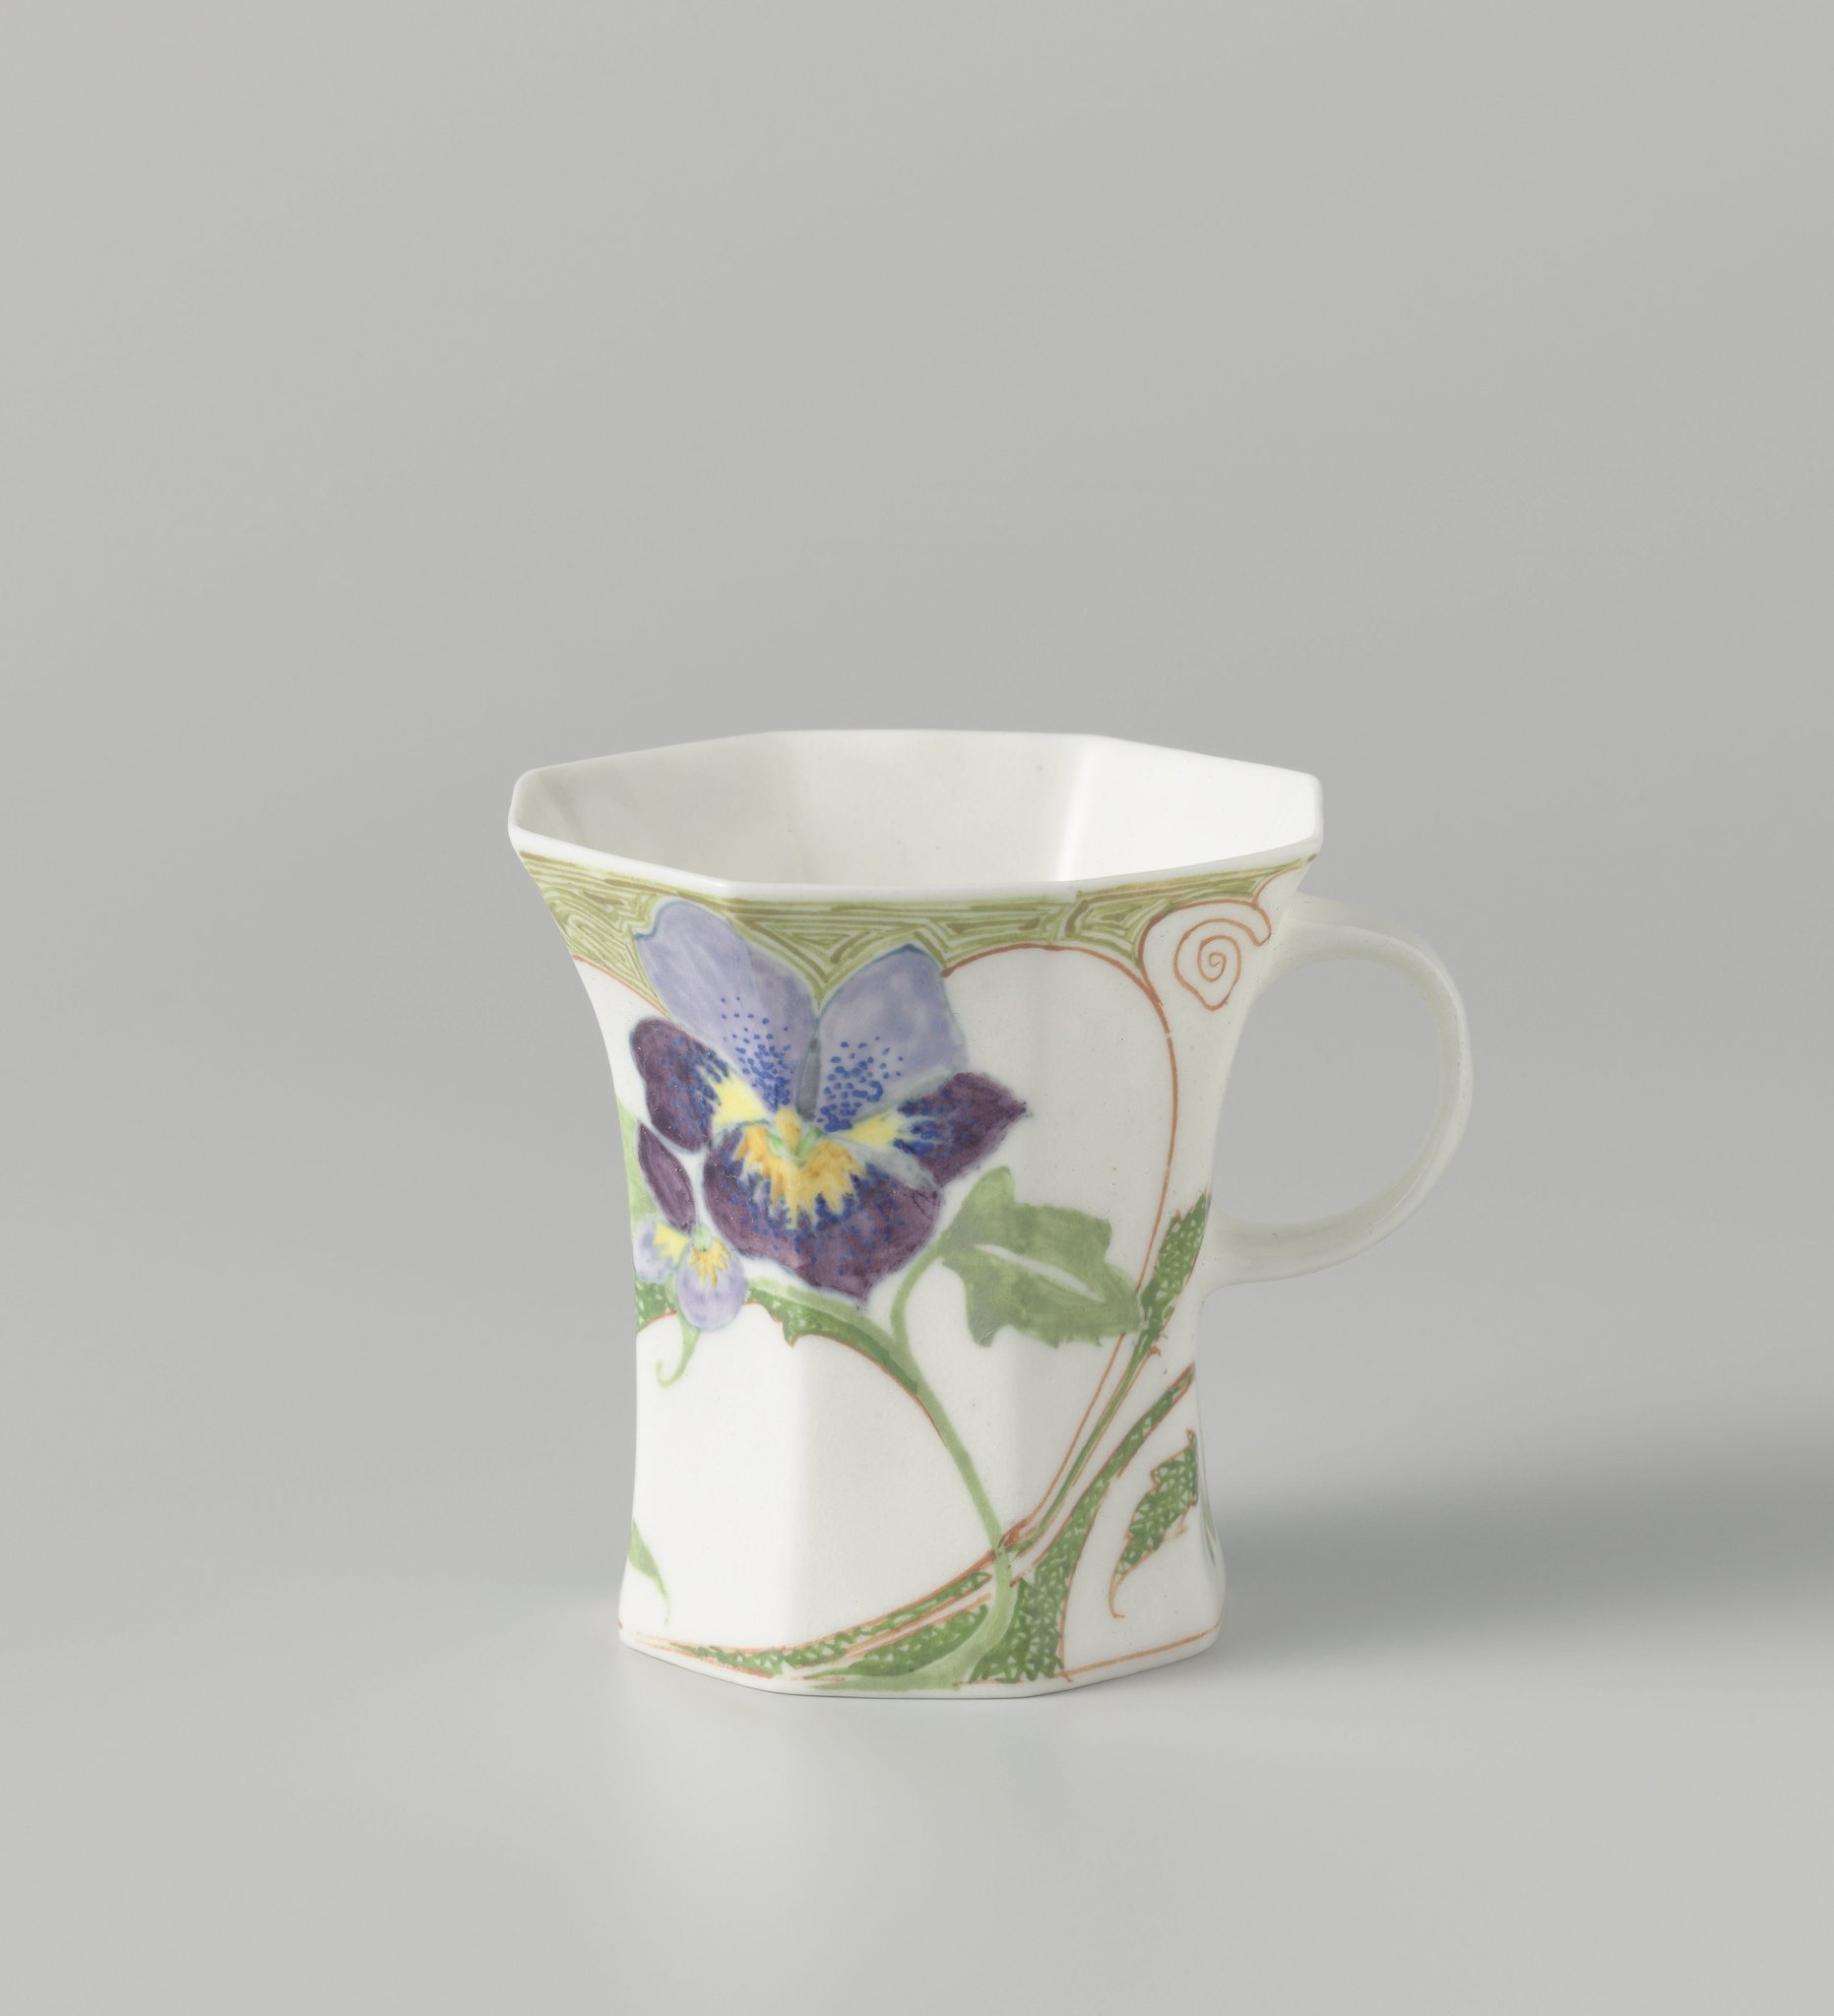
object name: cup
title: Kop, deel van een servies, beschilderd met violen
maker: c.w.j. t hart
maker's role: plateelschilder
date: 1913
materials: porcelain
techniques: painted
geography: the hague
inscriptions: mark: ‘kroon, Rozenburg, ooievaar, den Haag (boven elkaar); links het merk voor 1913, rechts het werkordernummer 332 (op een kop 333); onder het schildersmerk van C.W.J. 't Hart.’